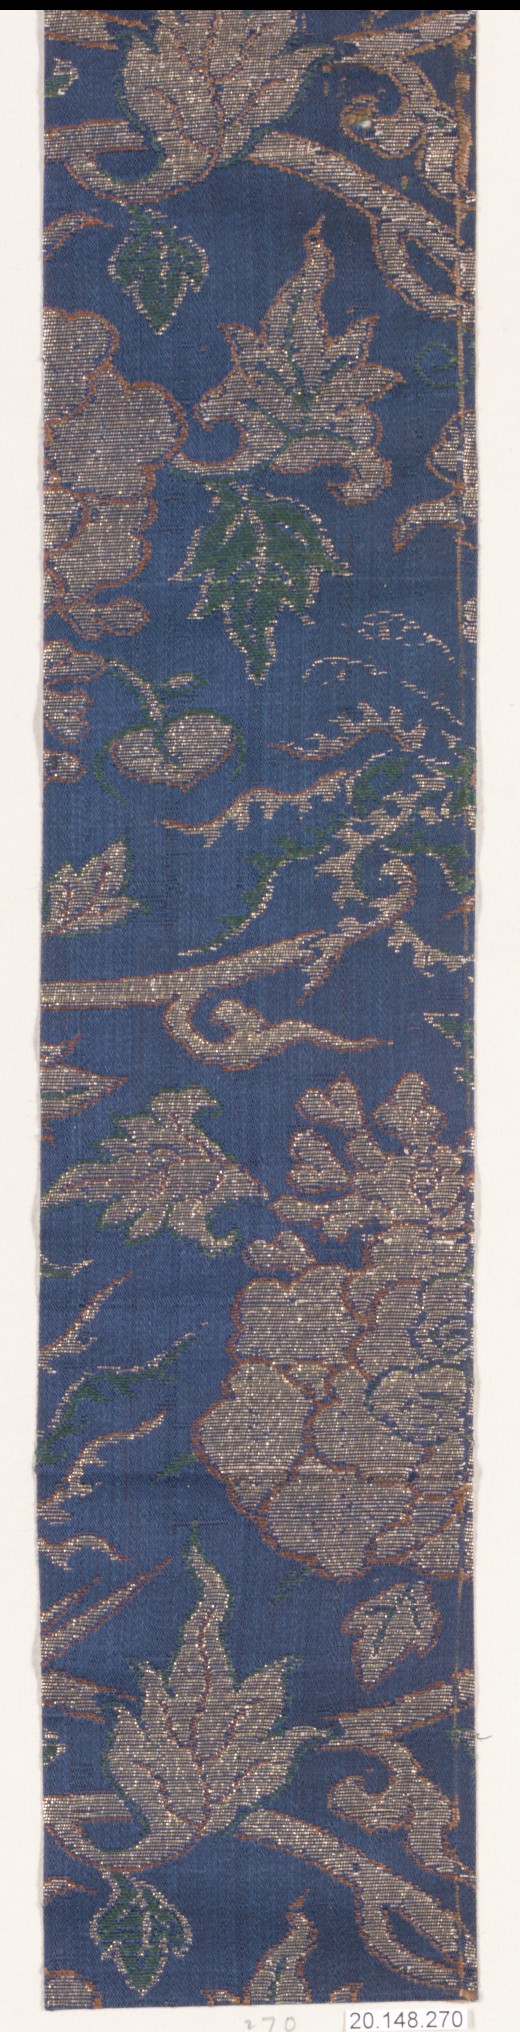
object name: piece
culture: japanese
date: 1601-1700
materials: silk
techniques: compound weave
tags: leaves